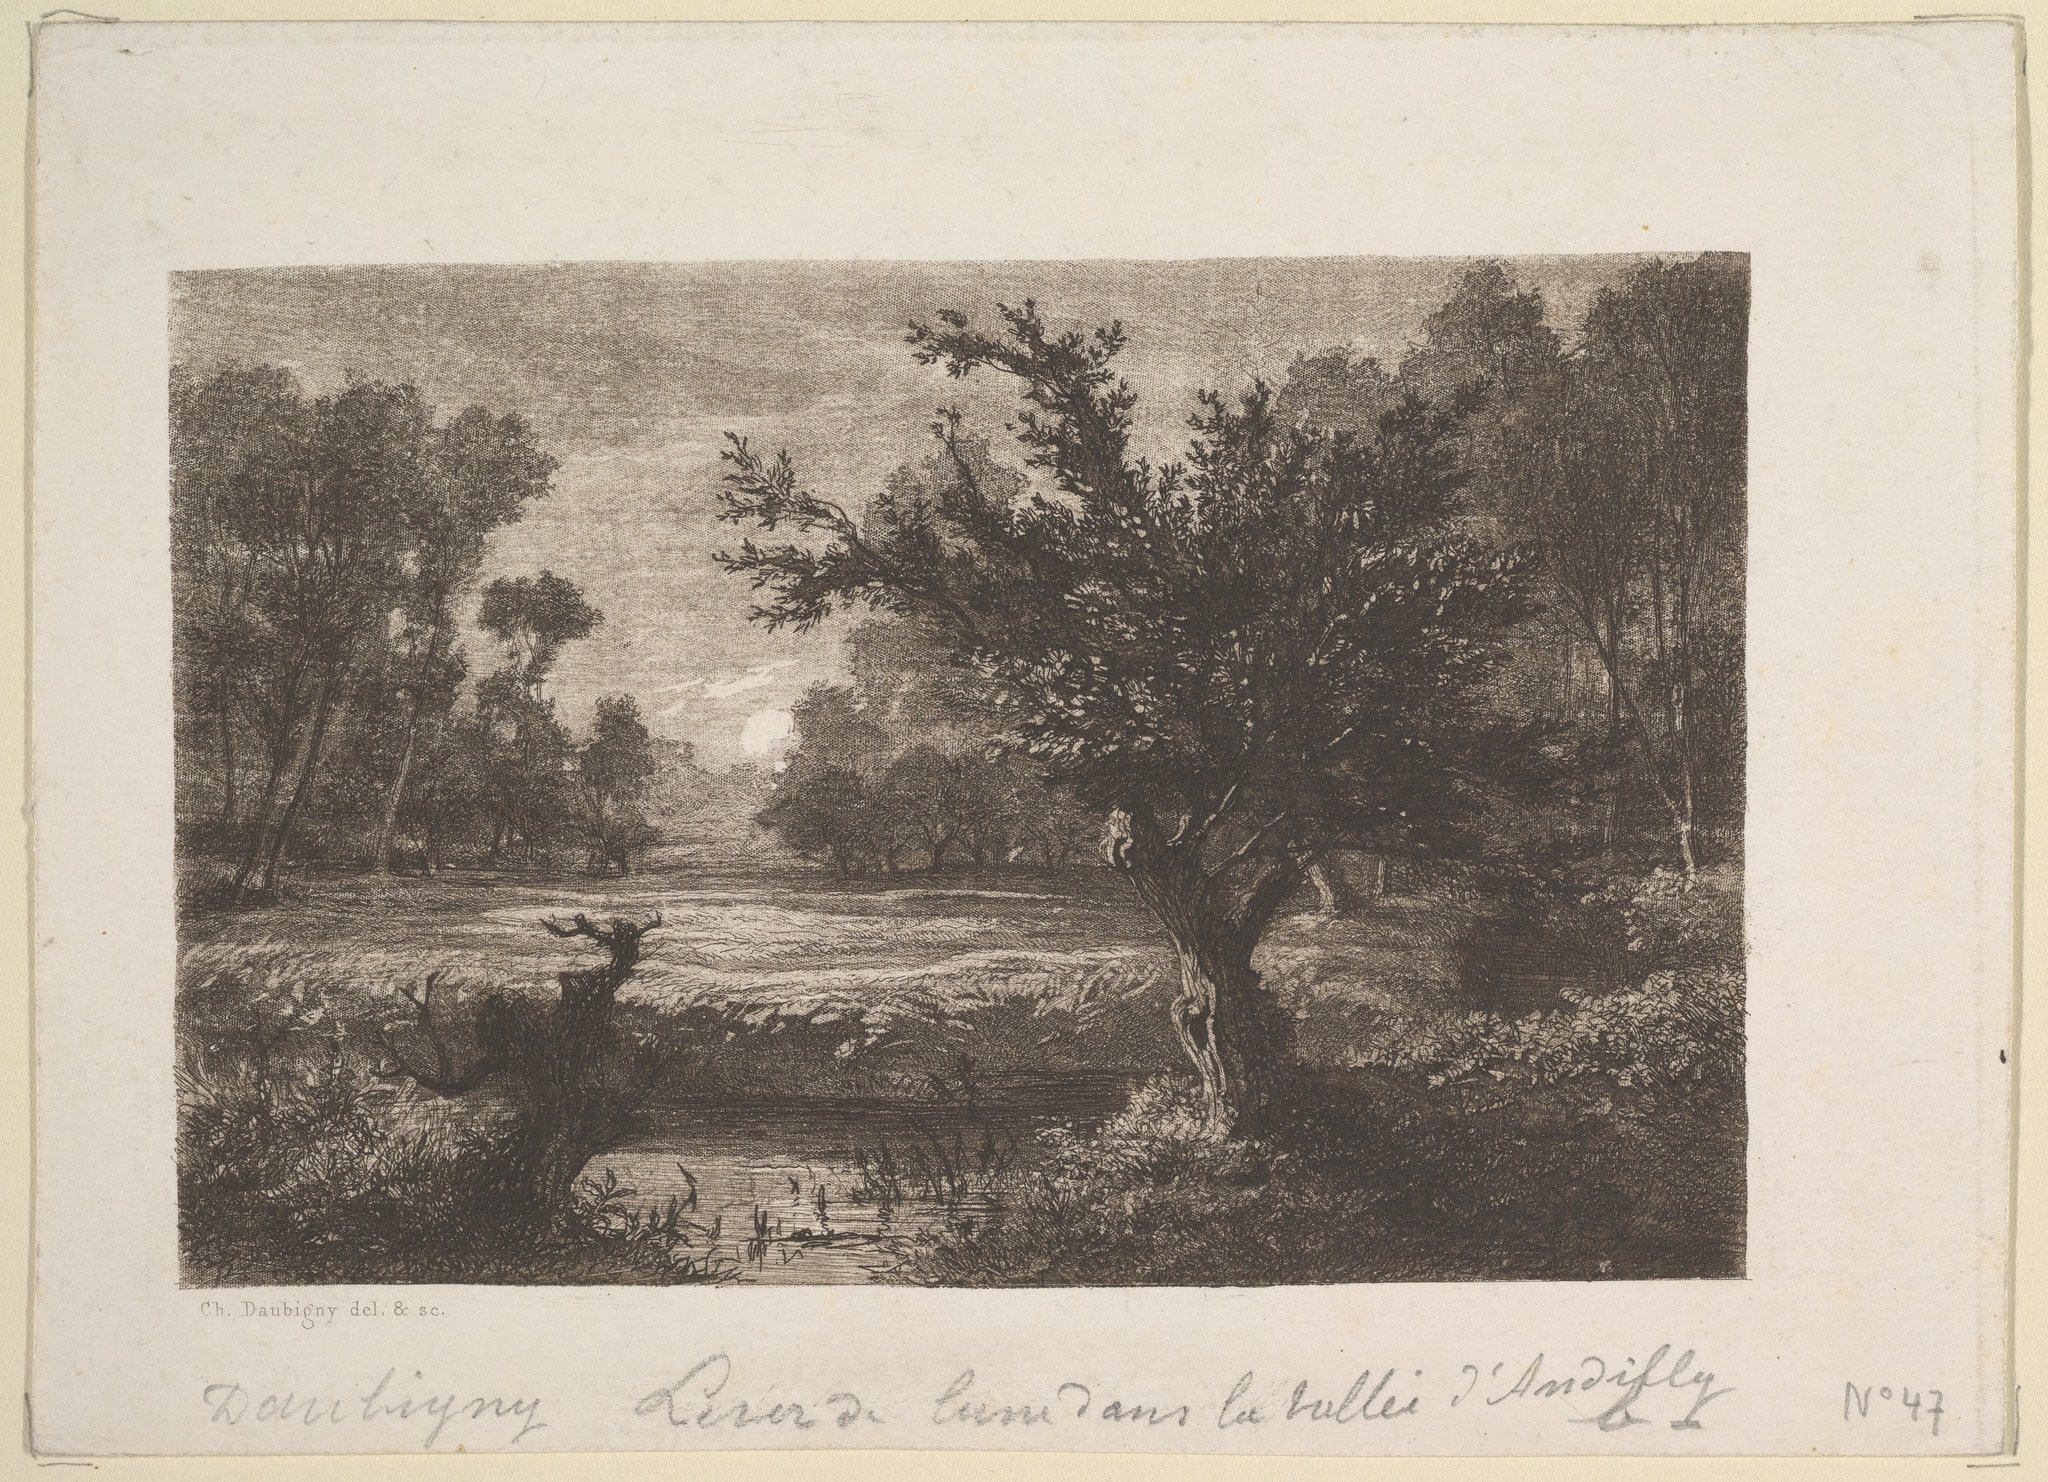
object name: print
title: Moonrise in the Valley of the Andilly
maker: charles-françois daubigny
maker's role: artist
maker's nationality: french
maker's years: 1817-1878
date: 1837-1878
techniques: etching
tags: moon,landscapes